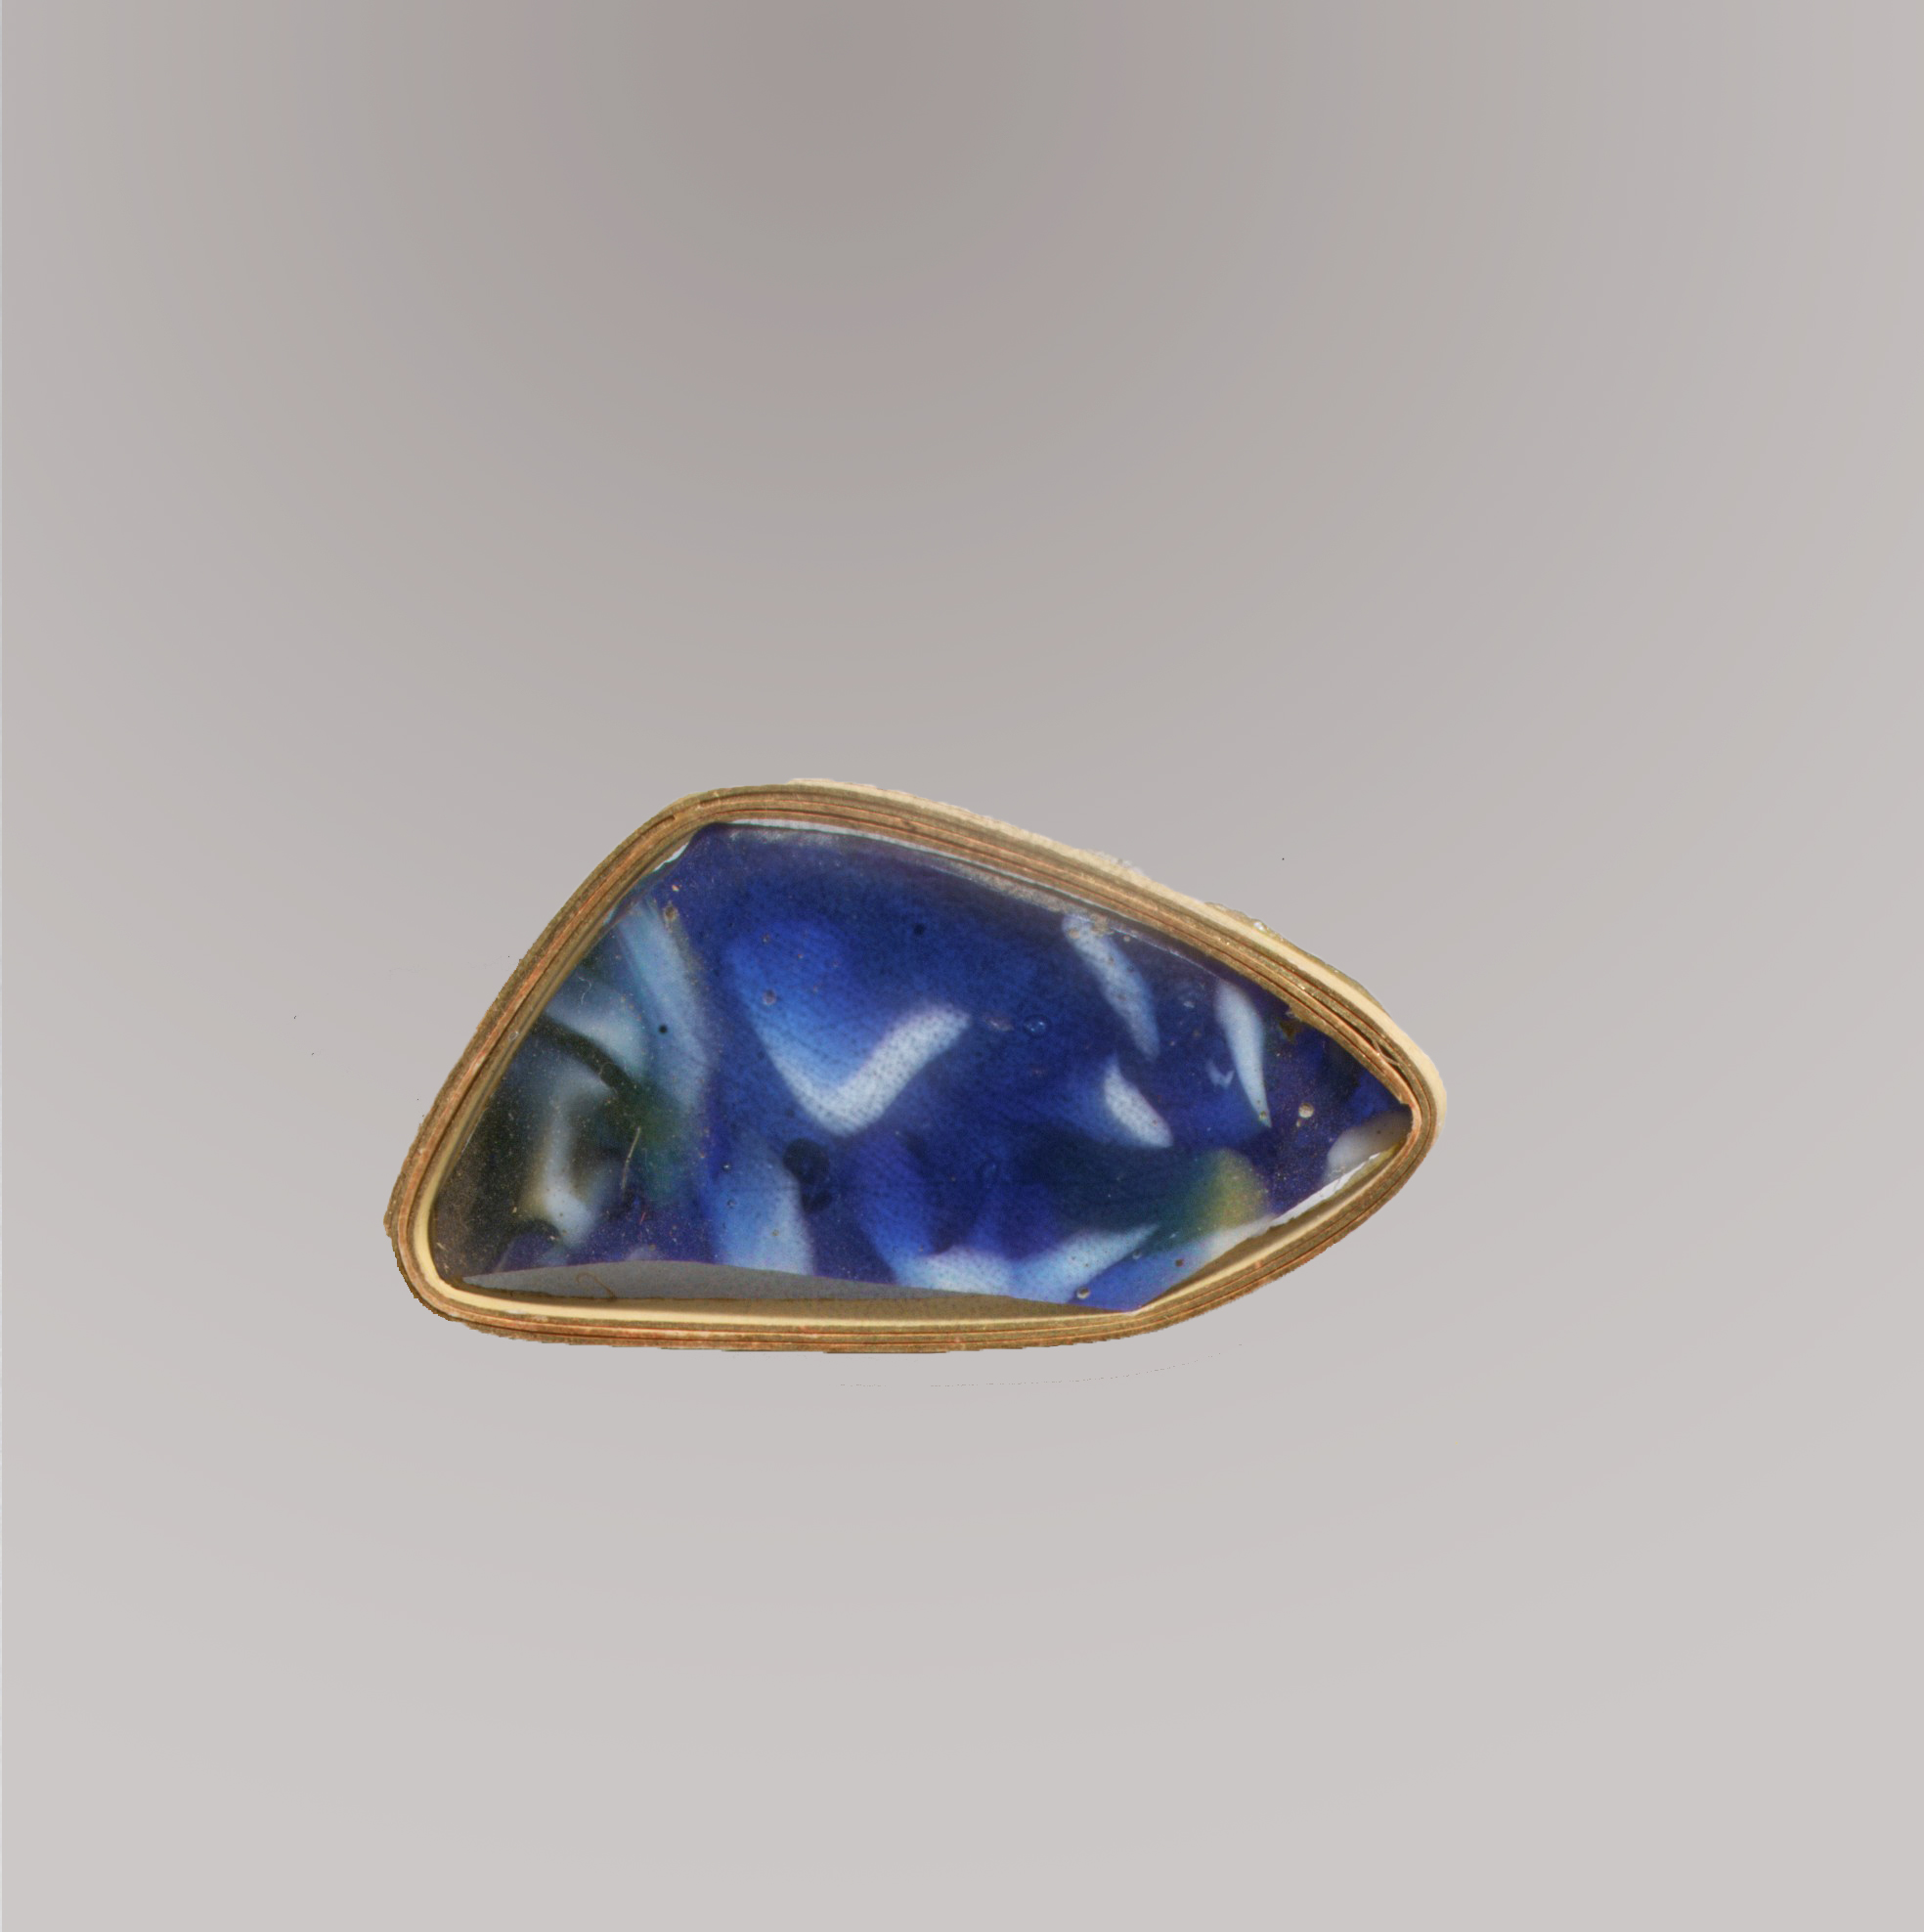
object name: fragment, mosaic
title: Glass mosaic fragment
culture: roman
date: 34 BCE-33 CE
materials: glass